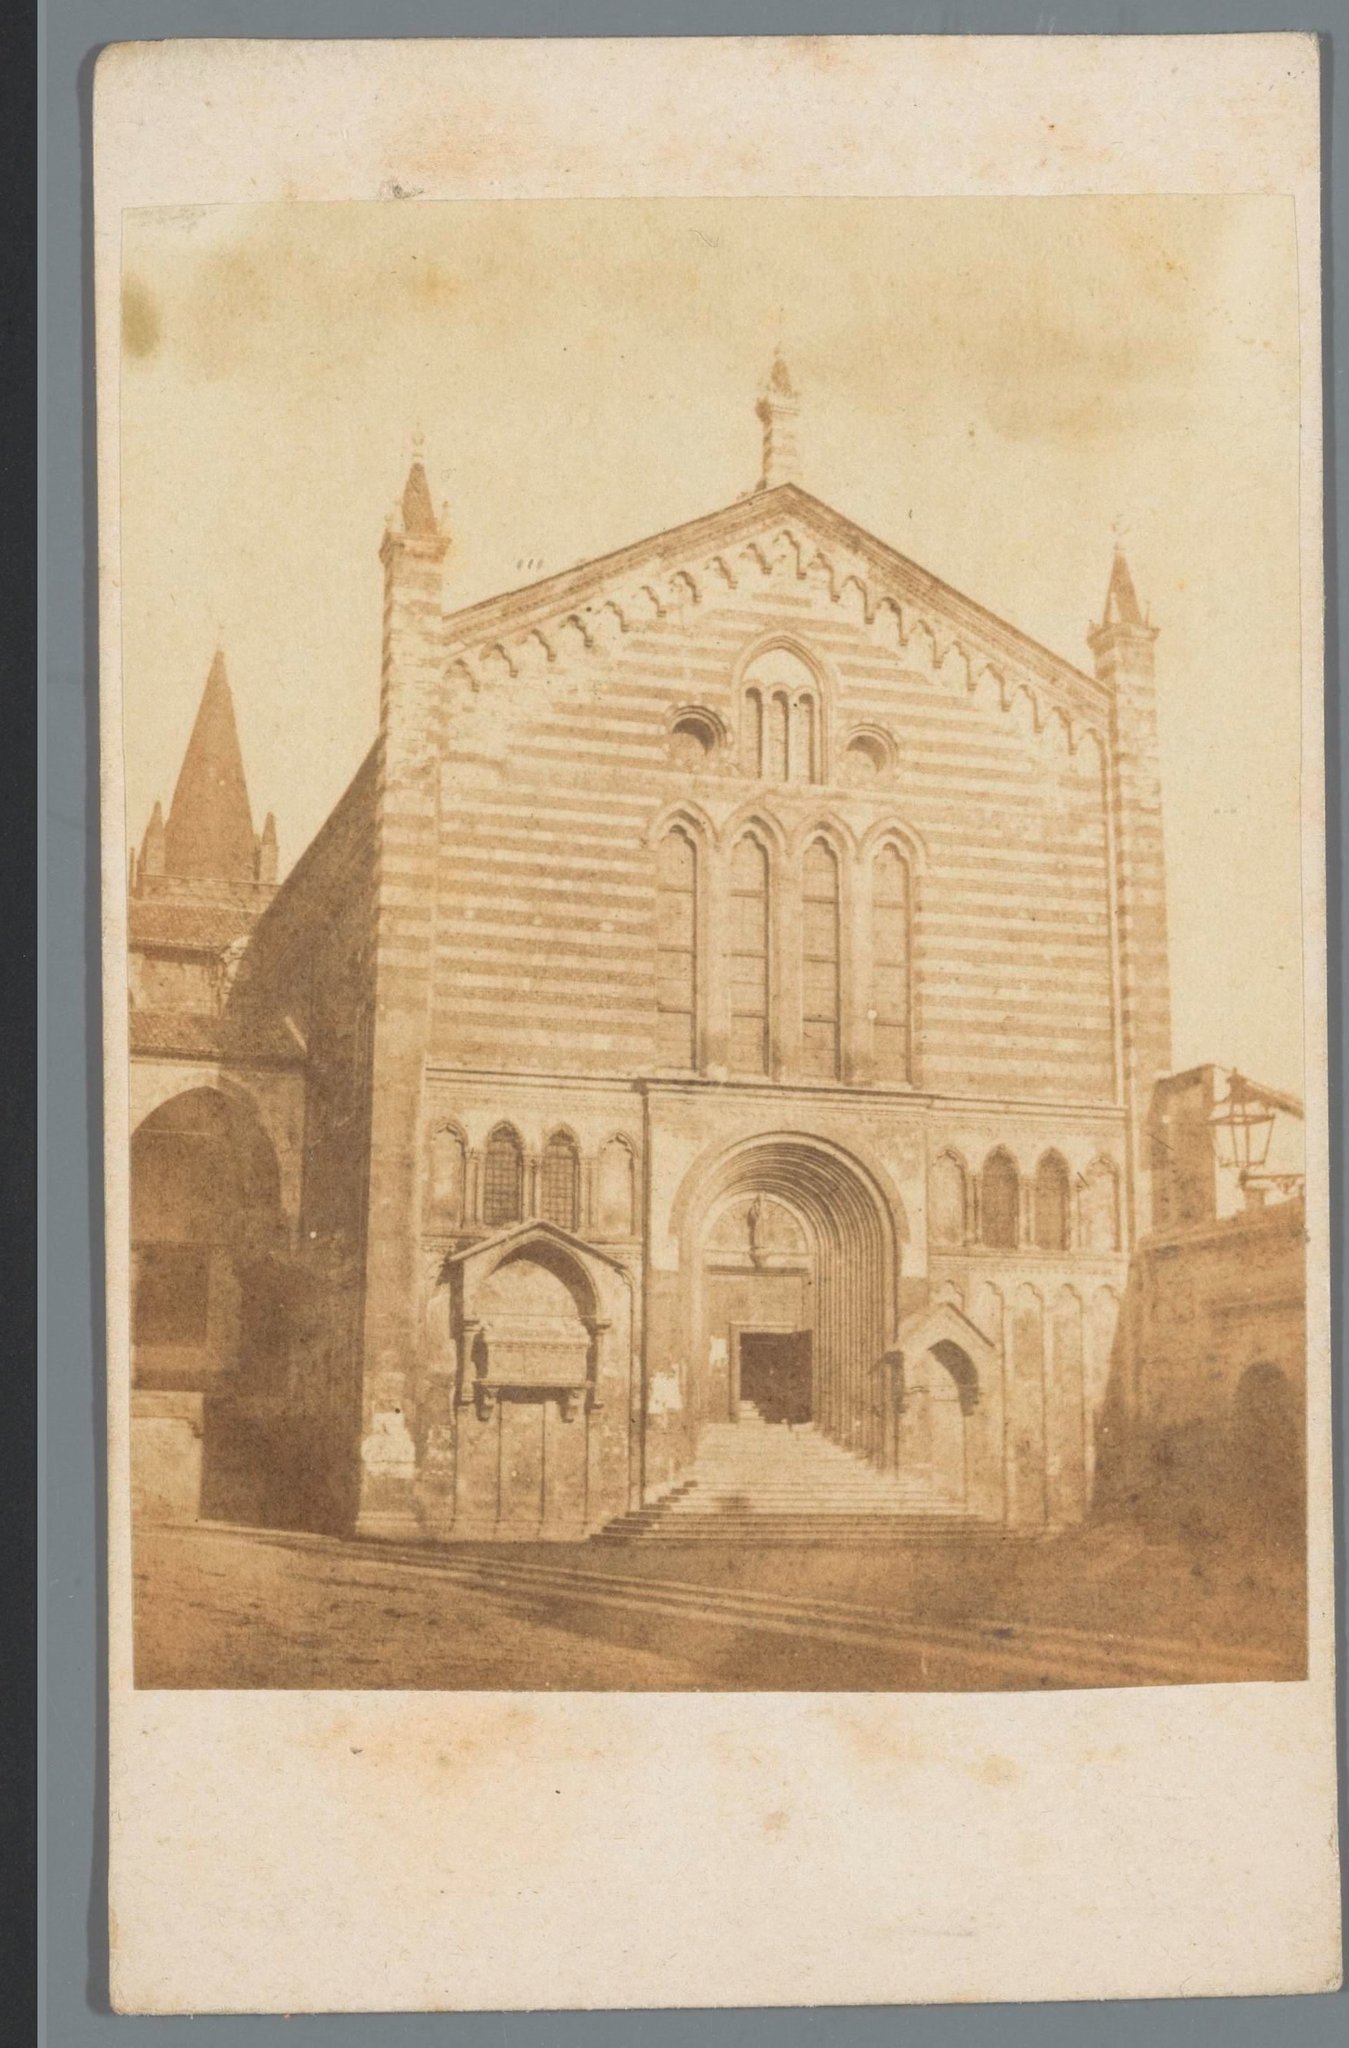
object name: photograph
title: San Fermo Maggiore, Verona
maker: Anonymous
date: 1855-1885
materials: cardboard, paper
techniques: albumen print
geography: verona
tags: church (exterior)